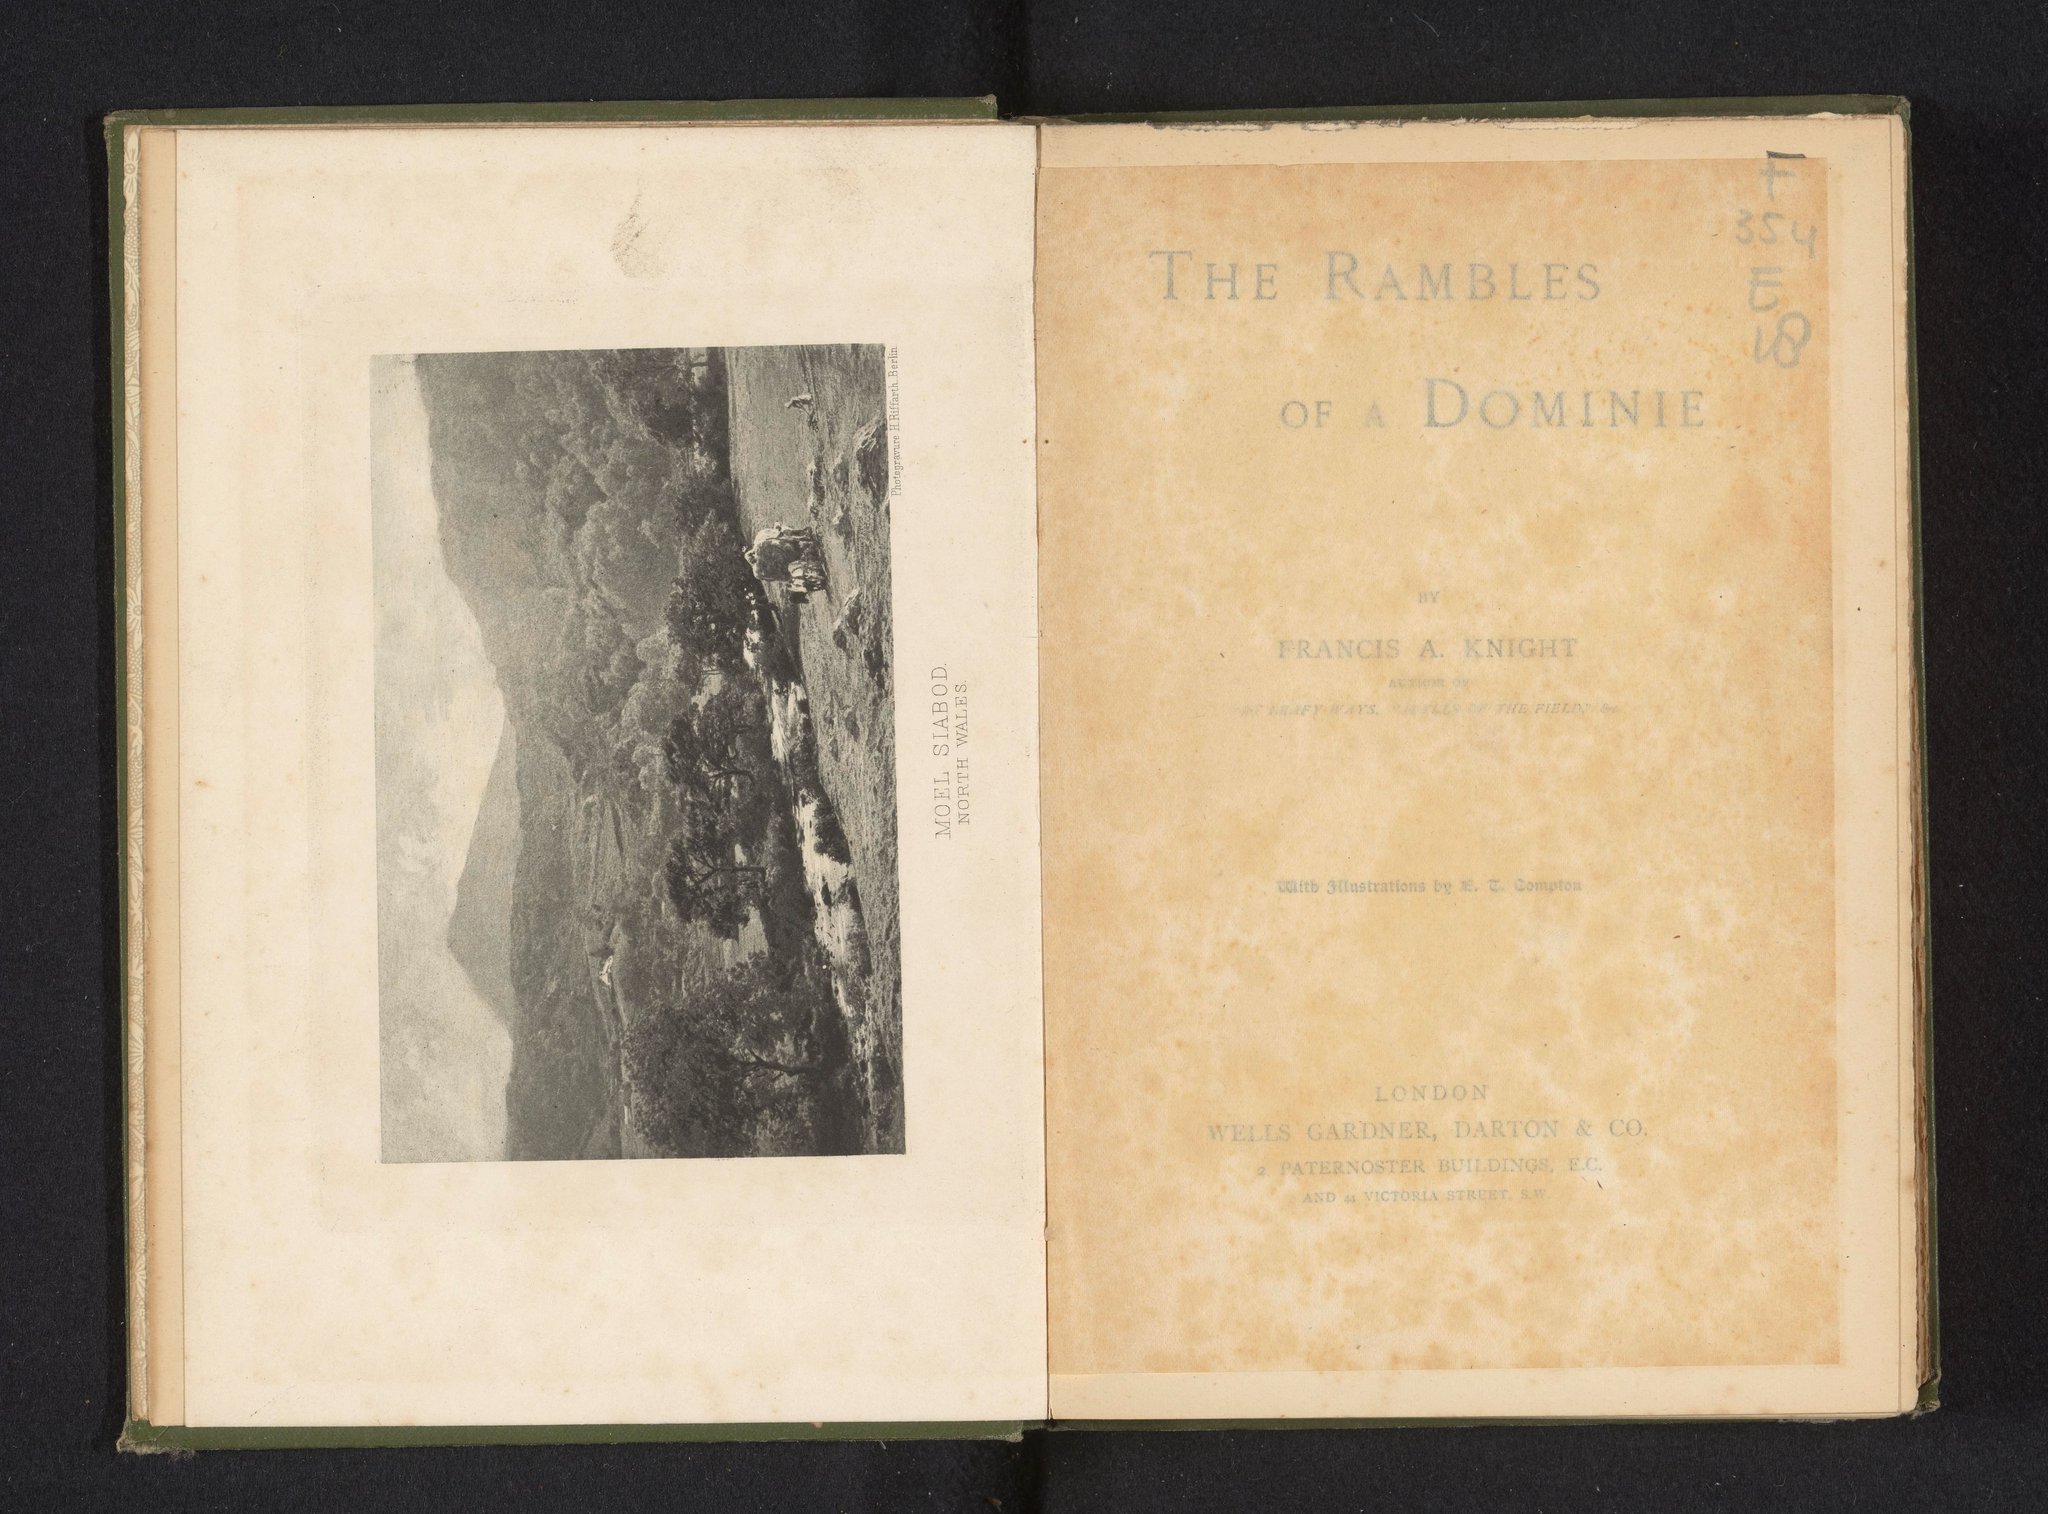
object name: photomechanical print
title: Moel Siabod. North Wales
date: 1886-1891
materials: paper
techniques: photoaquatint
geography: berlin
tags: mountains